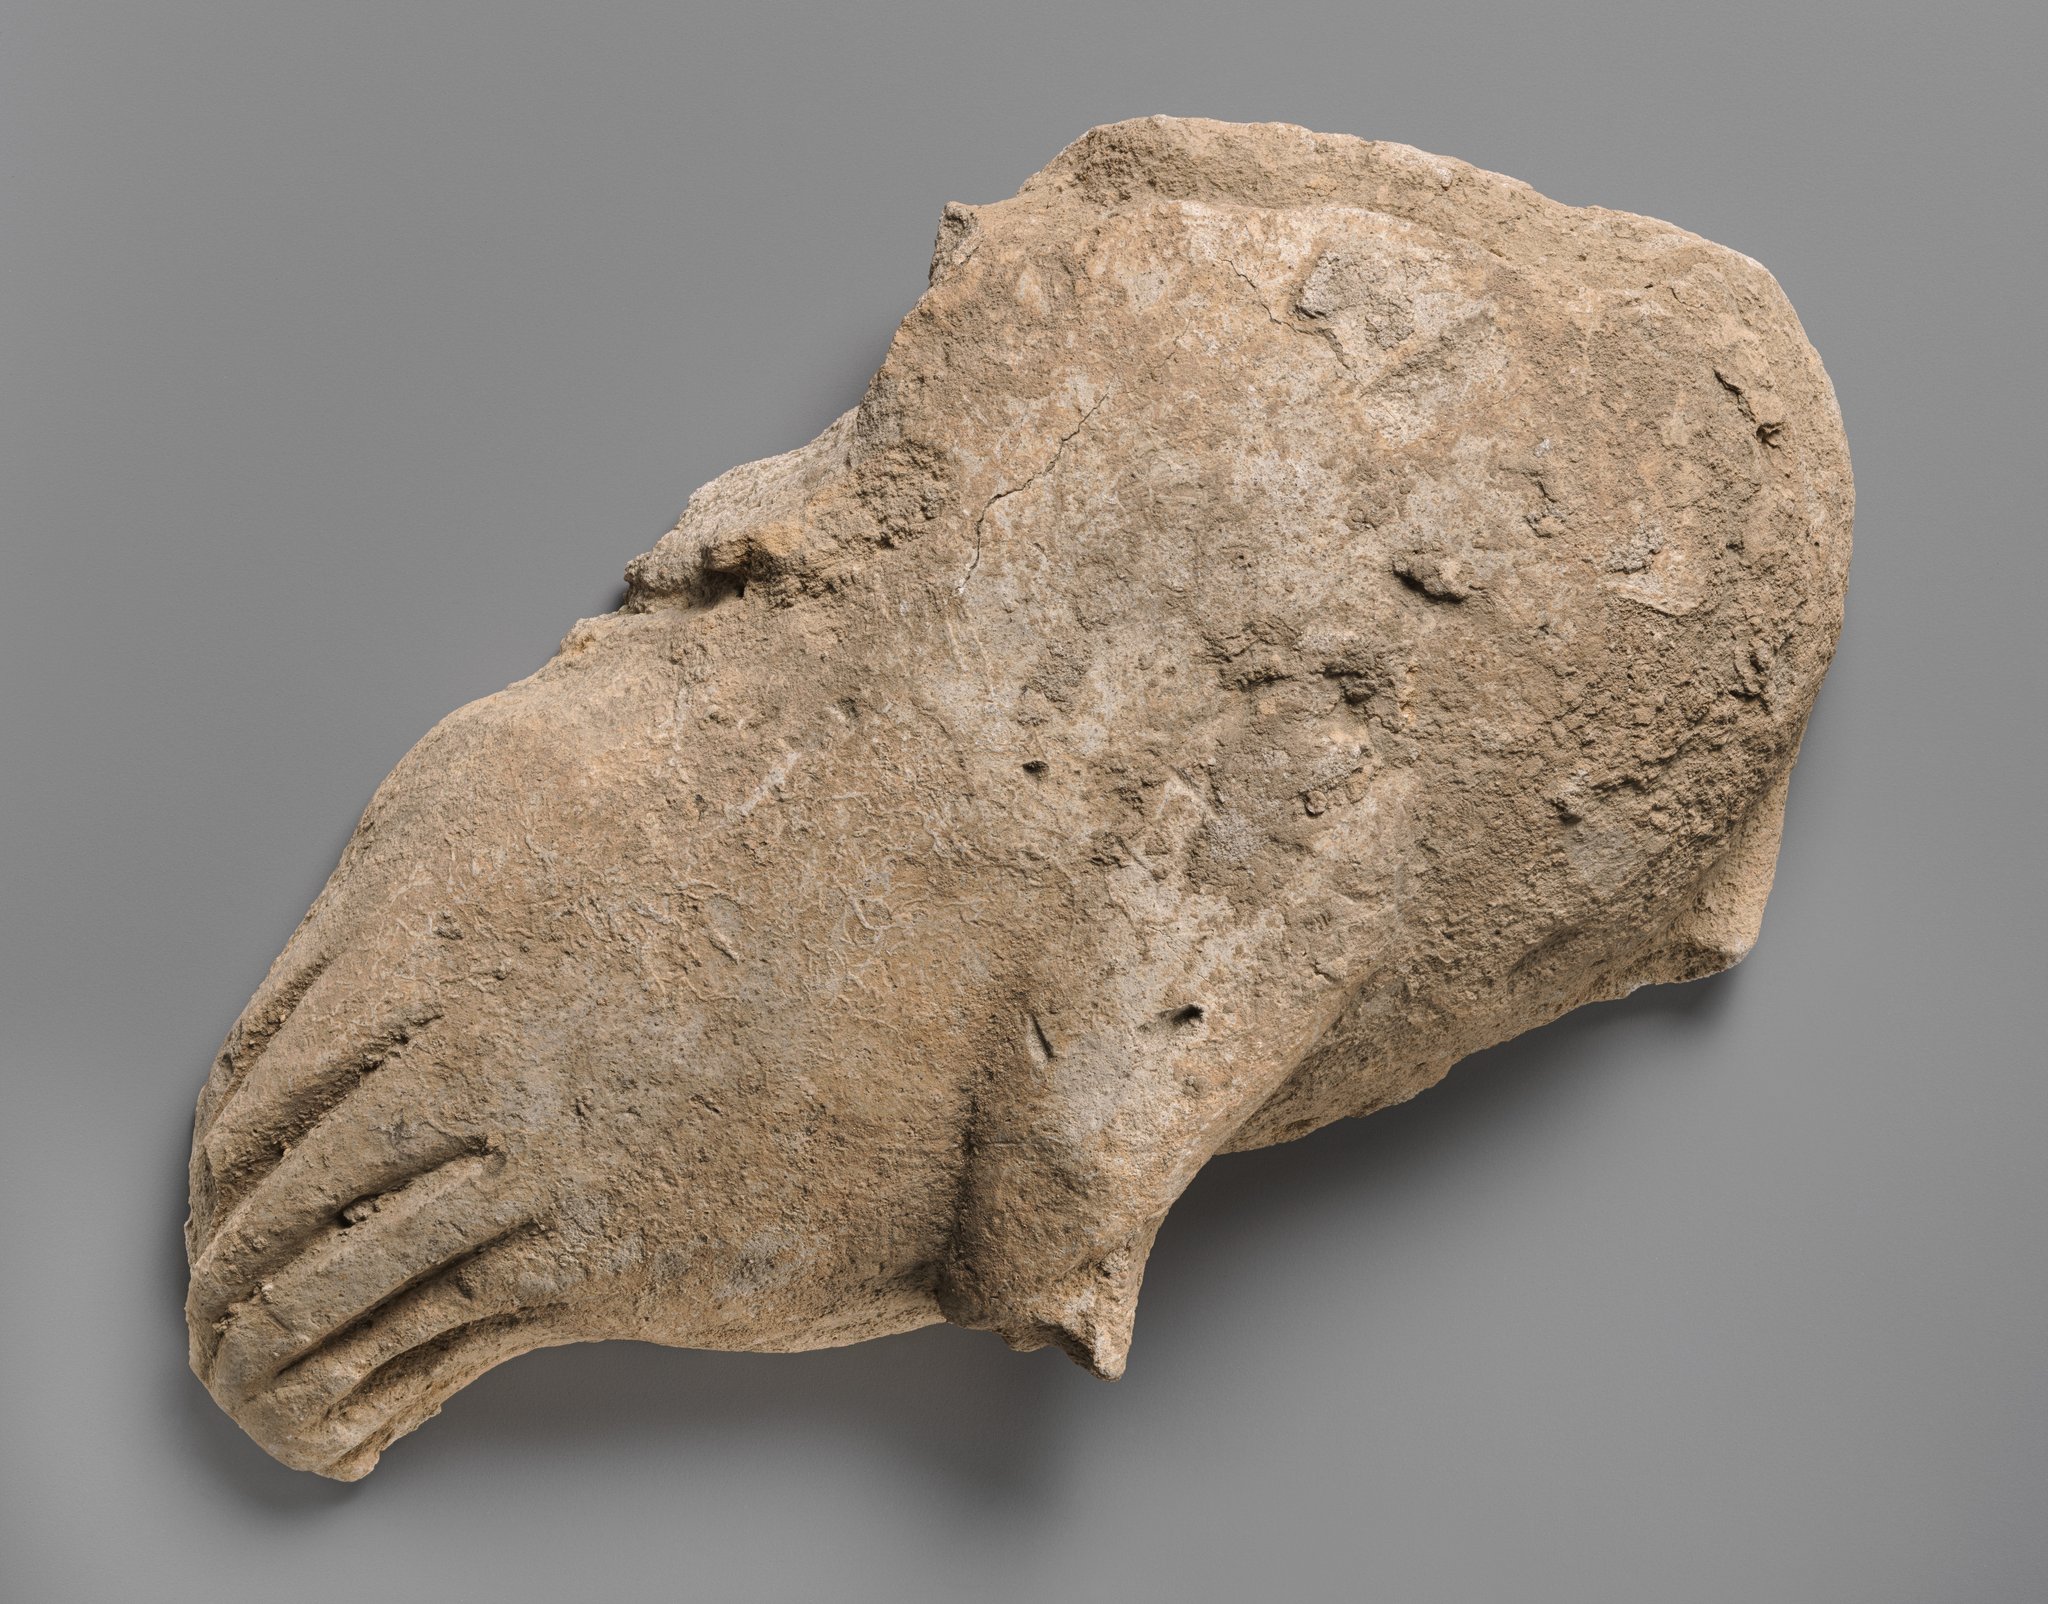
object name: relief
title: Fragment of a wall decoration with part of a bird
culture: sasanian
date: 501-600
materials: plaster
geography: mesopotamia